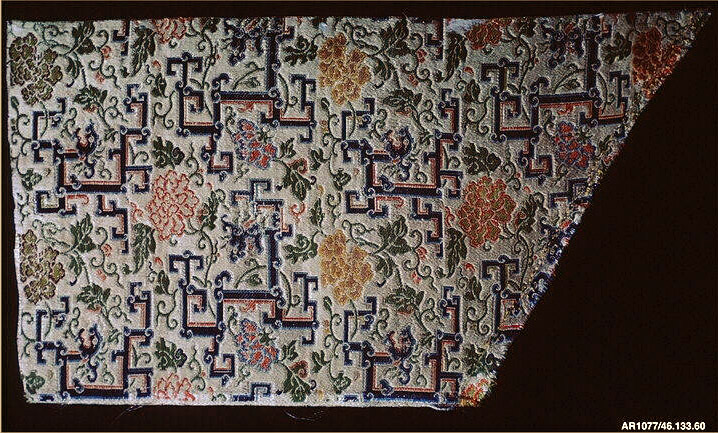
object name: piece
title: Textile with Peonies and Lattice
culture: chinese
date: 1701-1800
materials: silk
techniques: lampas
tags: peonies